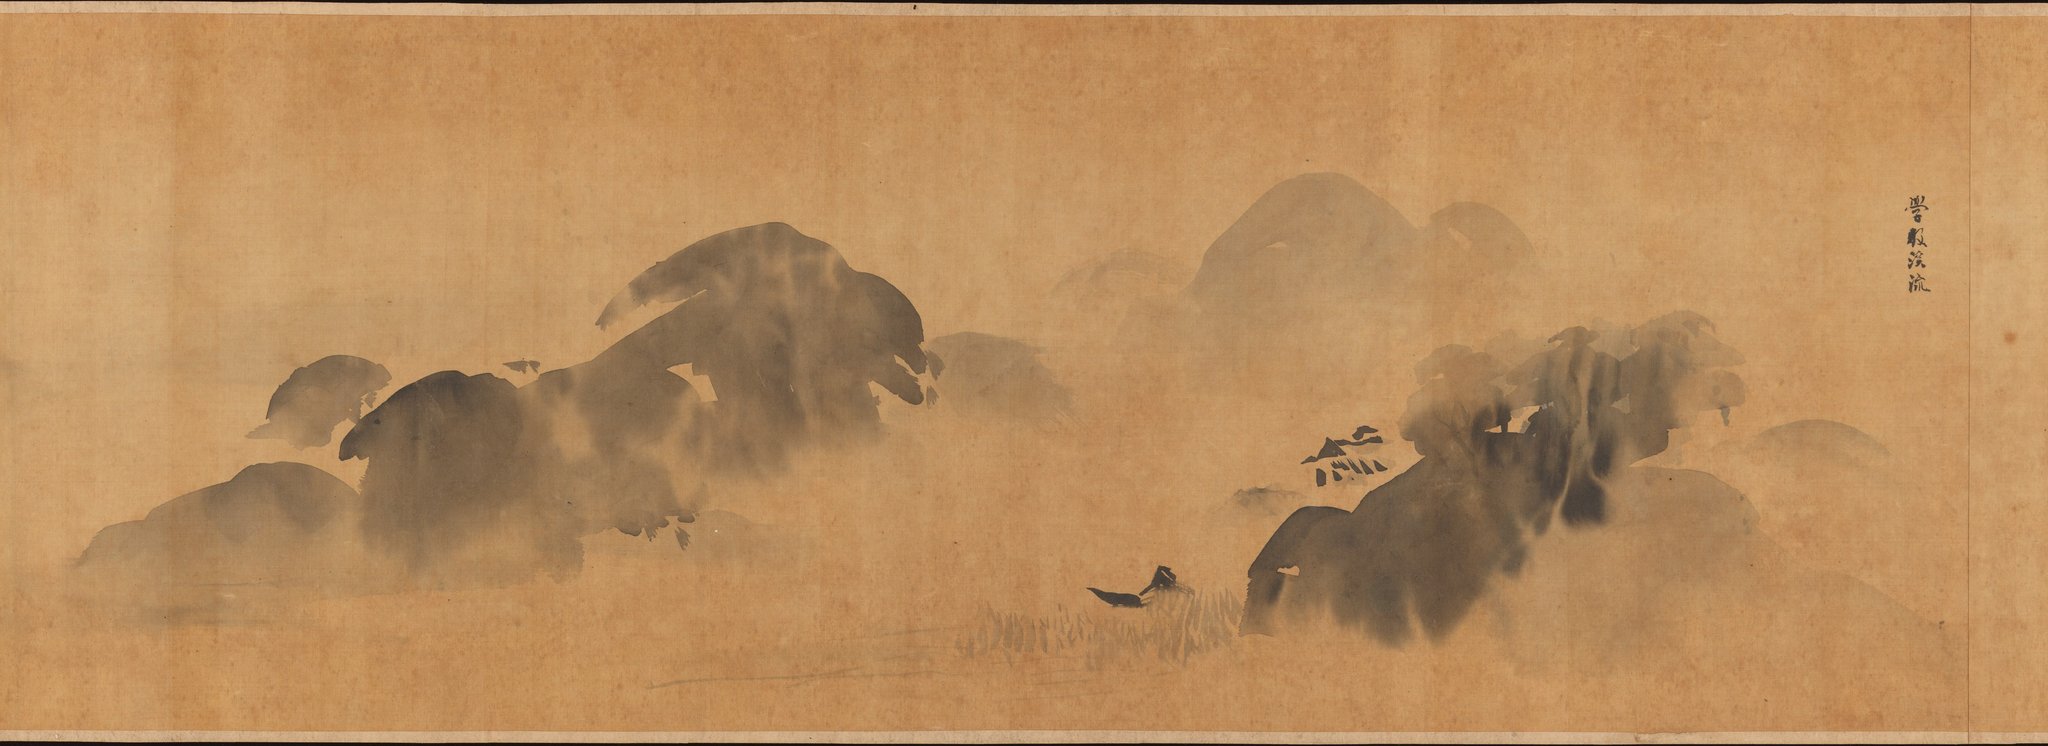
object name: handscroll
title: Famous Themes for Painting Study Known as “The Garden of Painting” (Gaen)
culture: japanese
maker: kano tan'yū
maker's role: artist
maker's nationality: japanese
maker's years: 1602-1674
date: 1670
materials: ink, paper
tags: landscapes